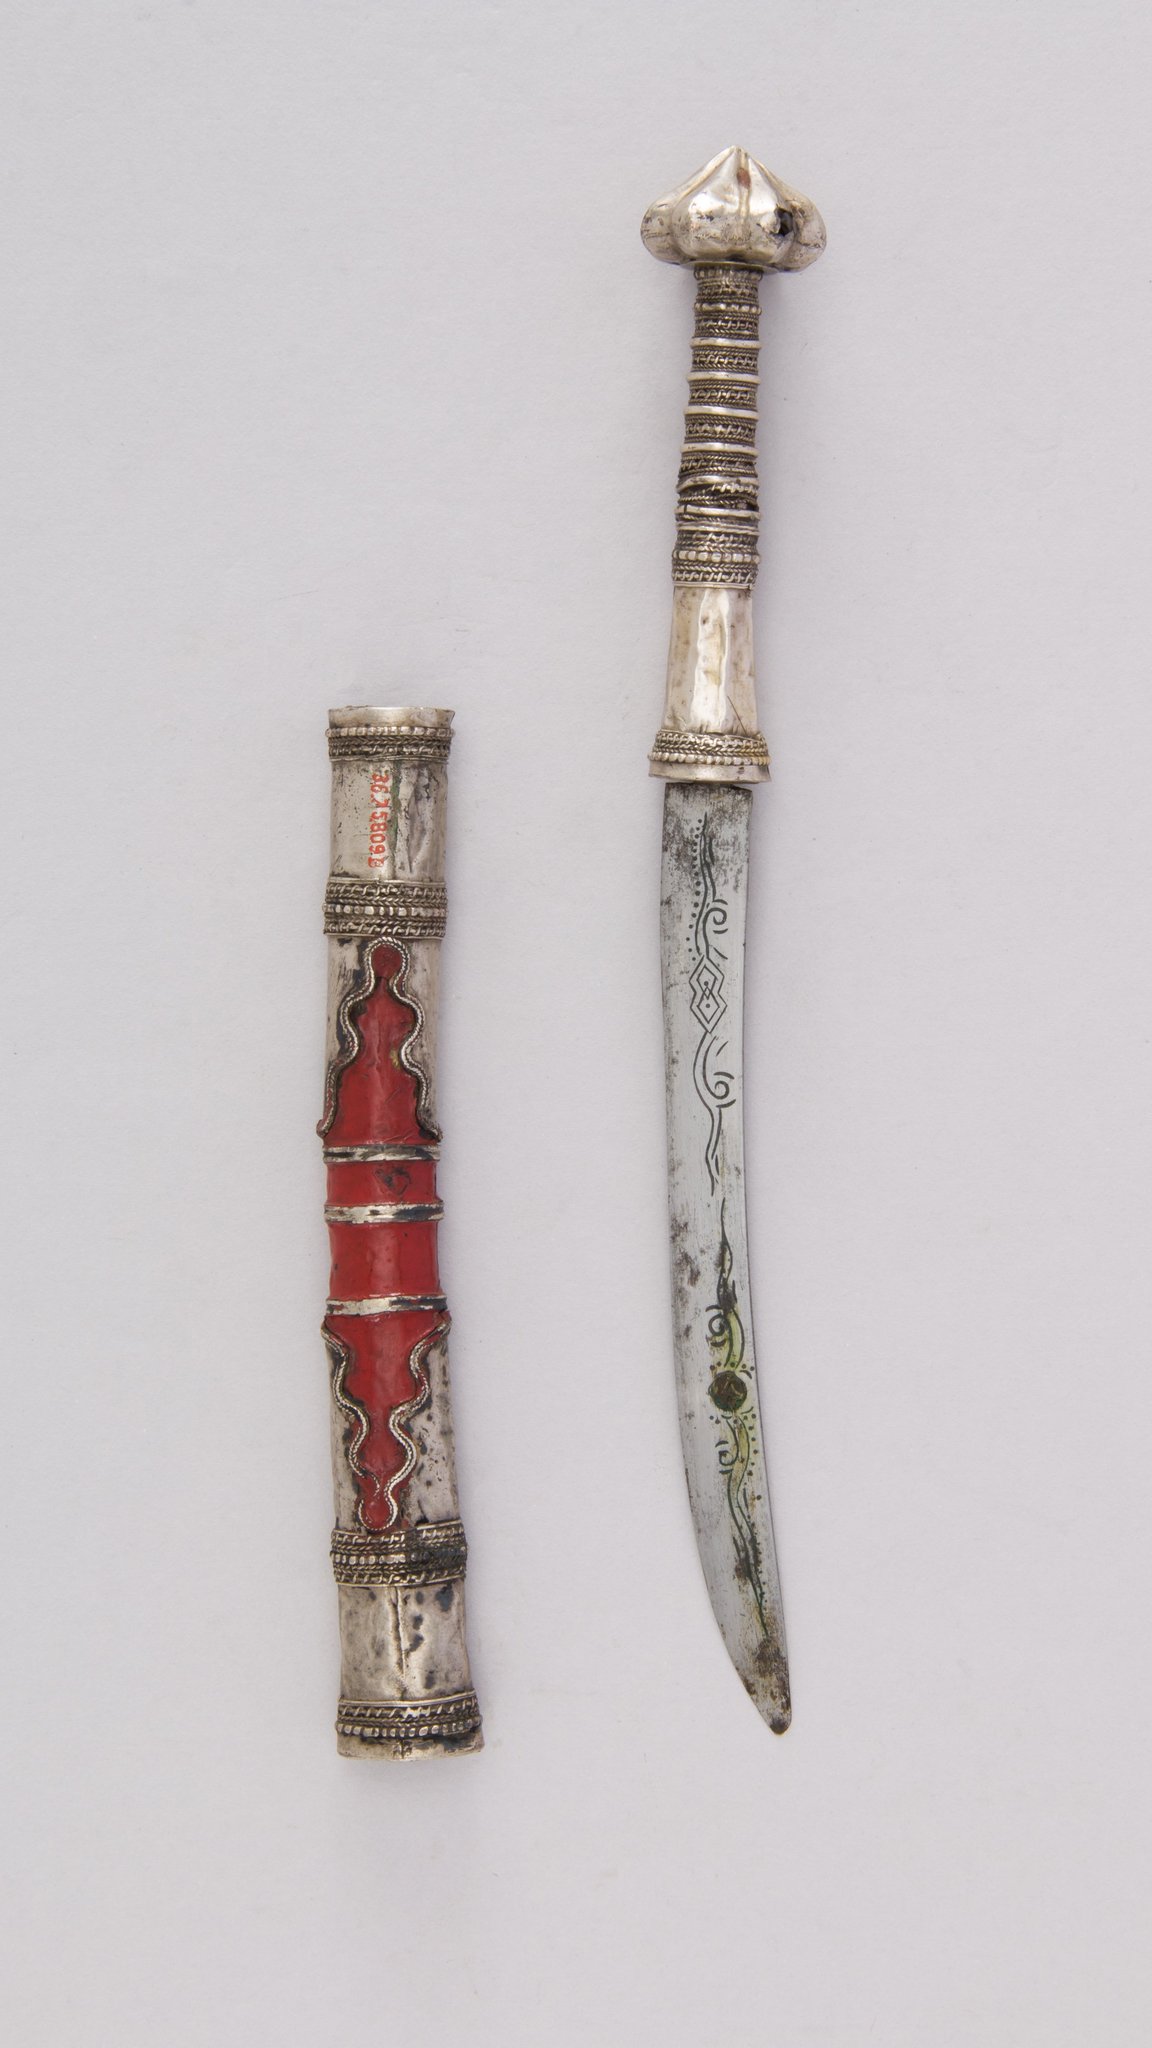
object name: knife dha with sheath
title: Knife (Dha) with Sheath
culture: thai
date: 1701-1900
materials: lacquer, silver, steel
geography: thailand